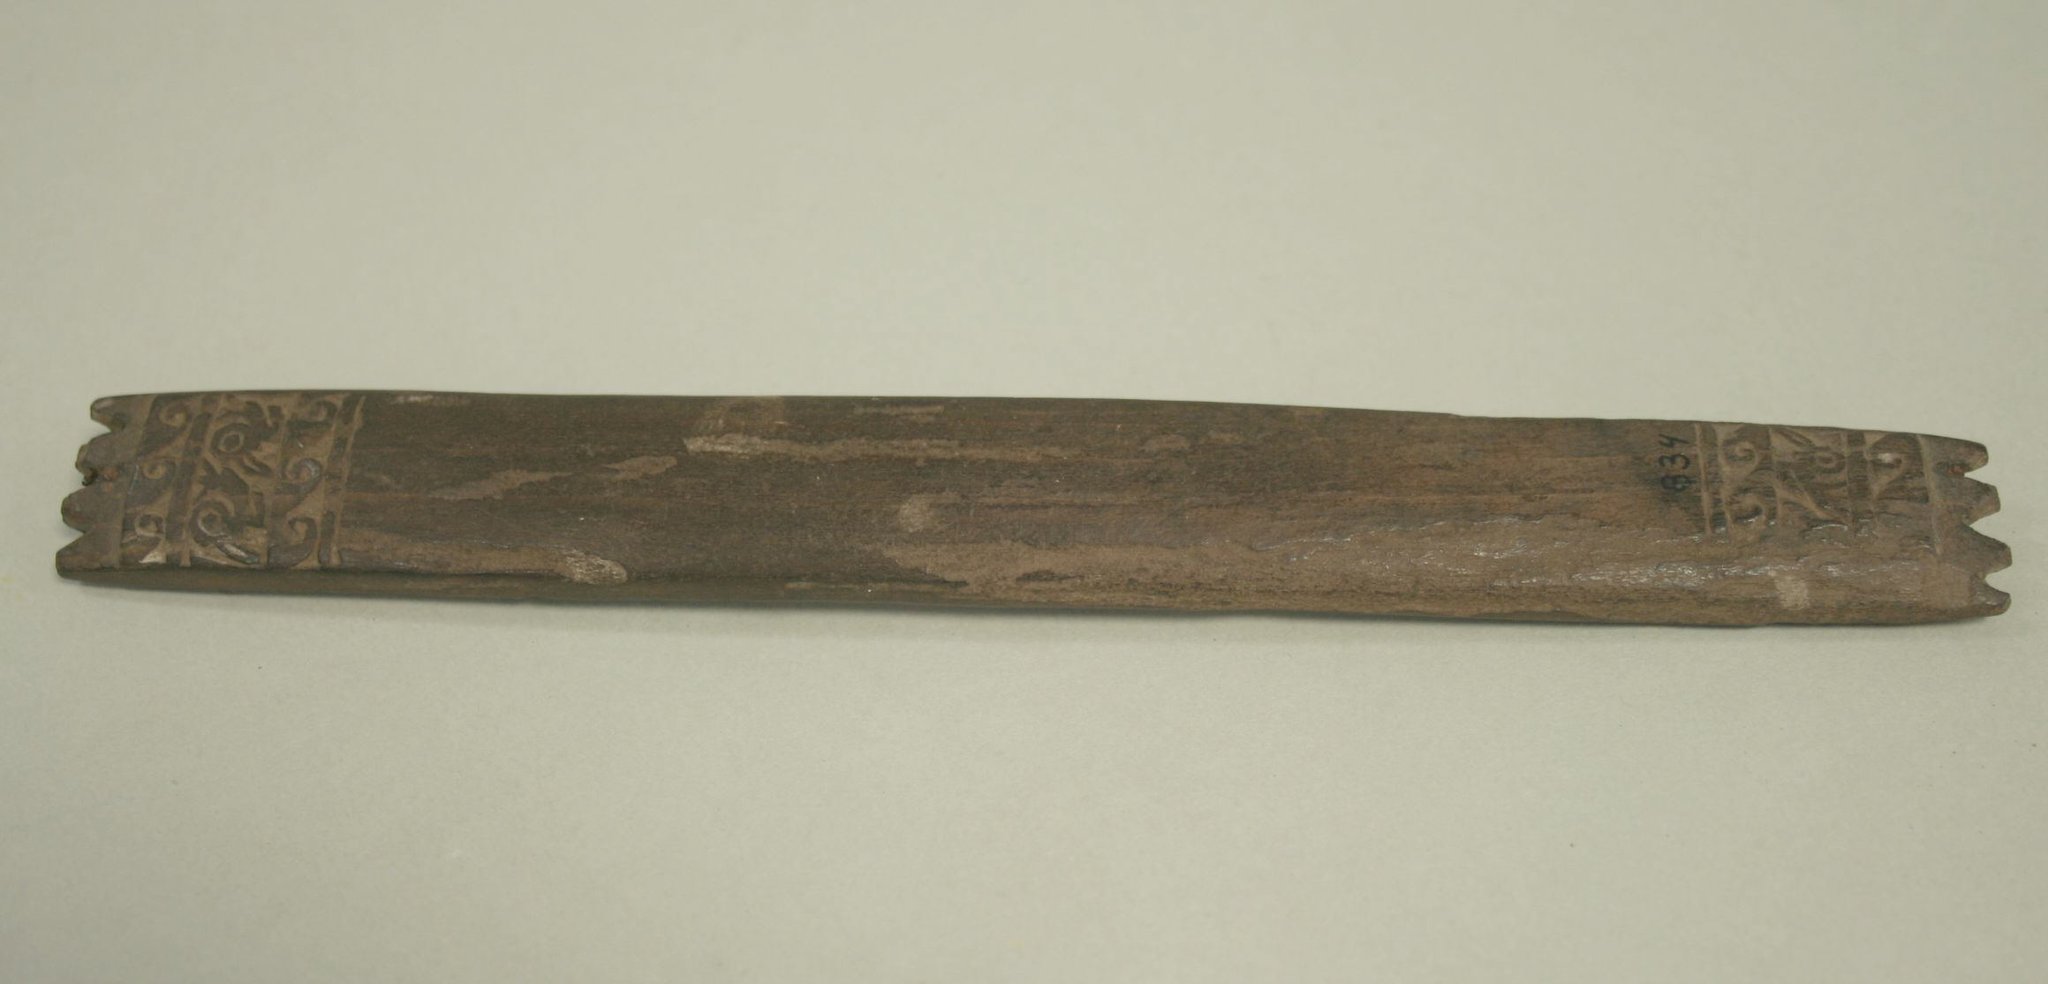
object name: weaving tool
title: Wooden Weaving Tool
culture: peruvian, north or central coast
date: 701-1566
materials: wood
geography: peru